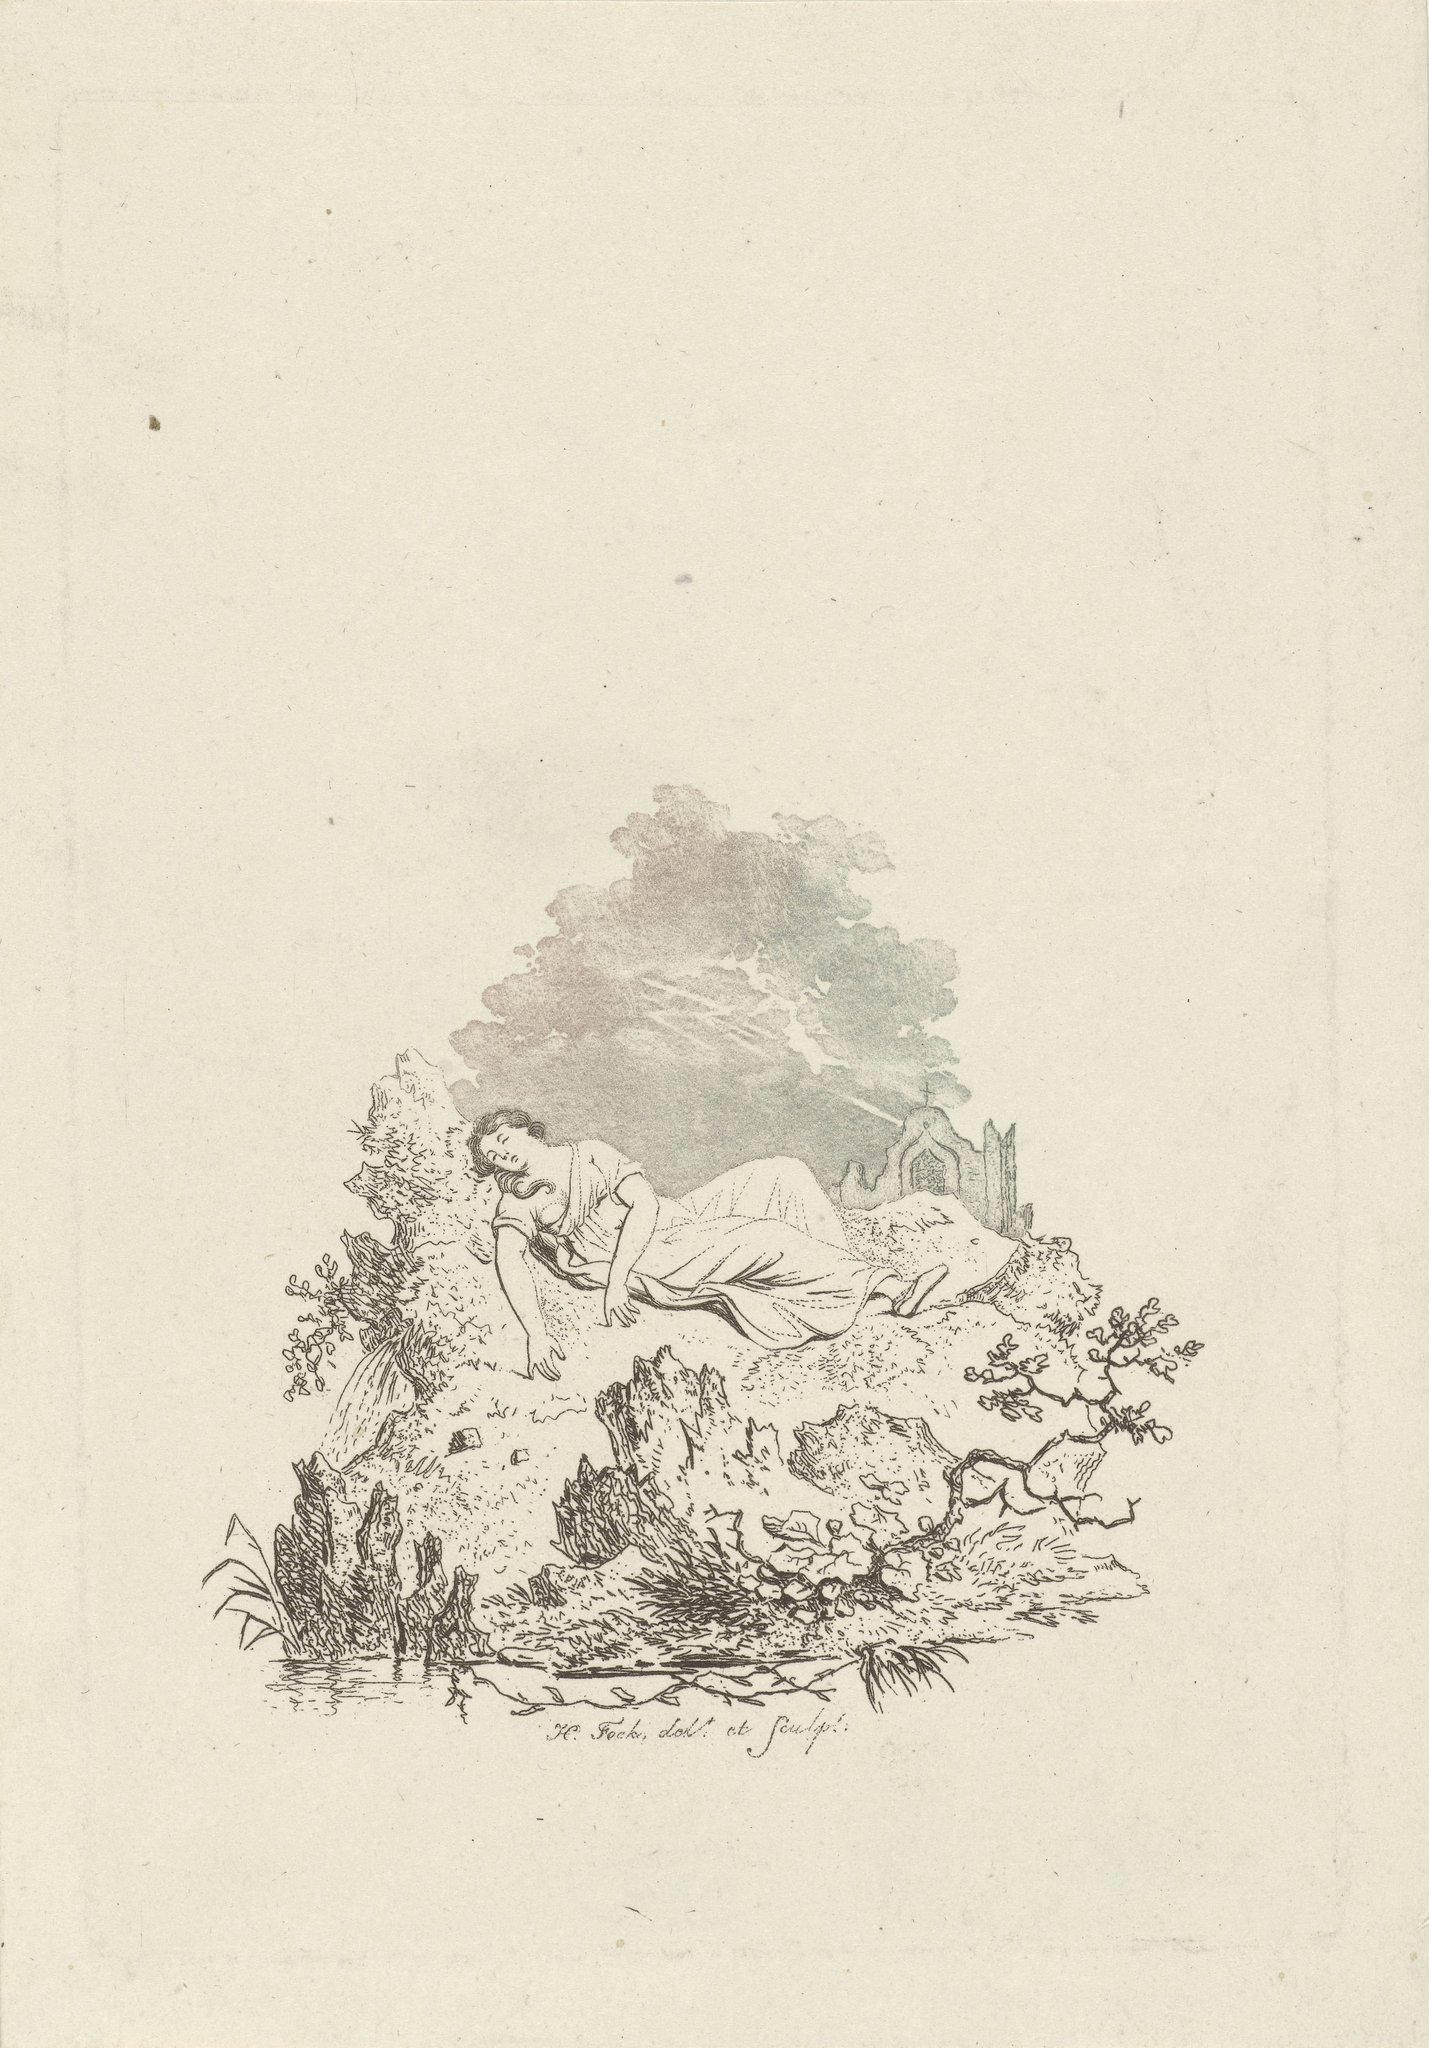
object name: print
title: De berggeest of het steenen bruidsbed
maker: hermanus fock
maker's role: conservator, draughtsman, painter, print maker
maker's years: 1766-1822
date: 1815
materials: paper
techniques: etching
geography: amsterdam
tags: sleeping; unconsciousness - bb - out of doors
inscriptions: collector's mark: Lugt 2228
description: Een rotslandschap met een slapende vrouw. Op de achtergrond een ruïne onder donkere wolken met bliksem. Illustratie gebruikt voor de titelpagina van De berggeest of het steenen bruidsbed, door A. Cramer, Amsterdam, 1815.